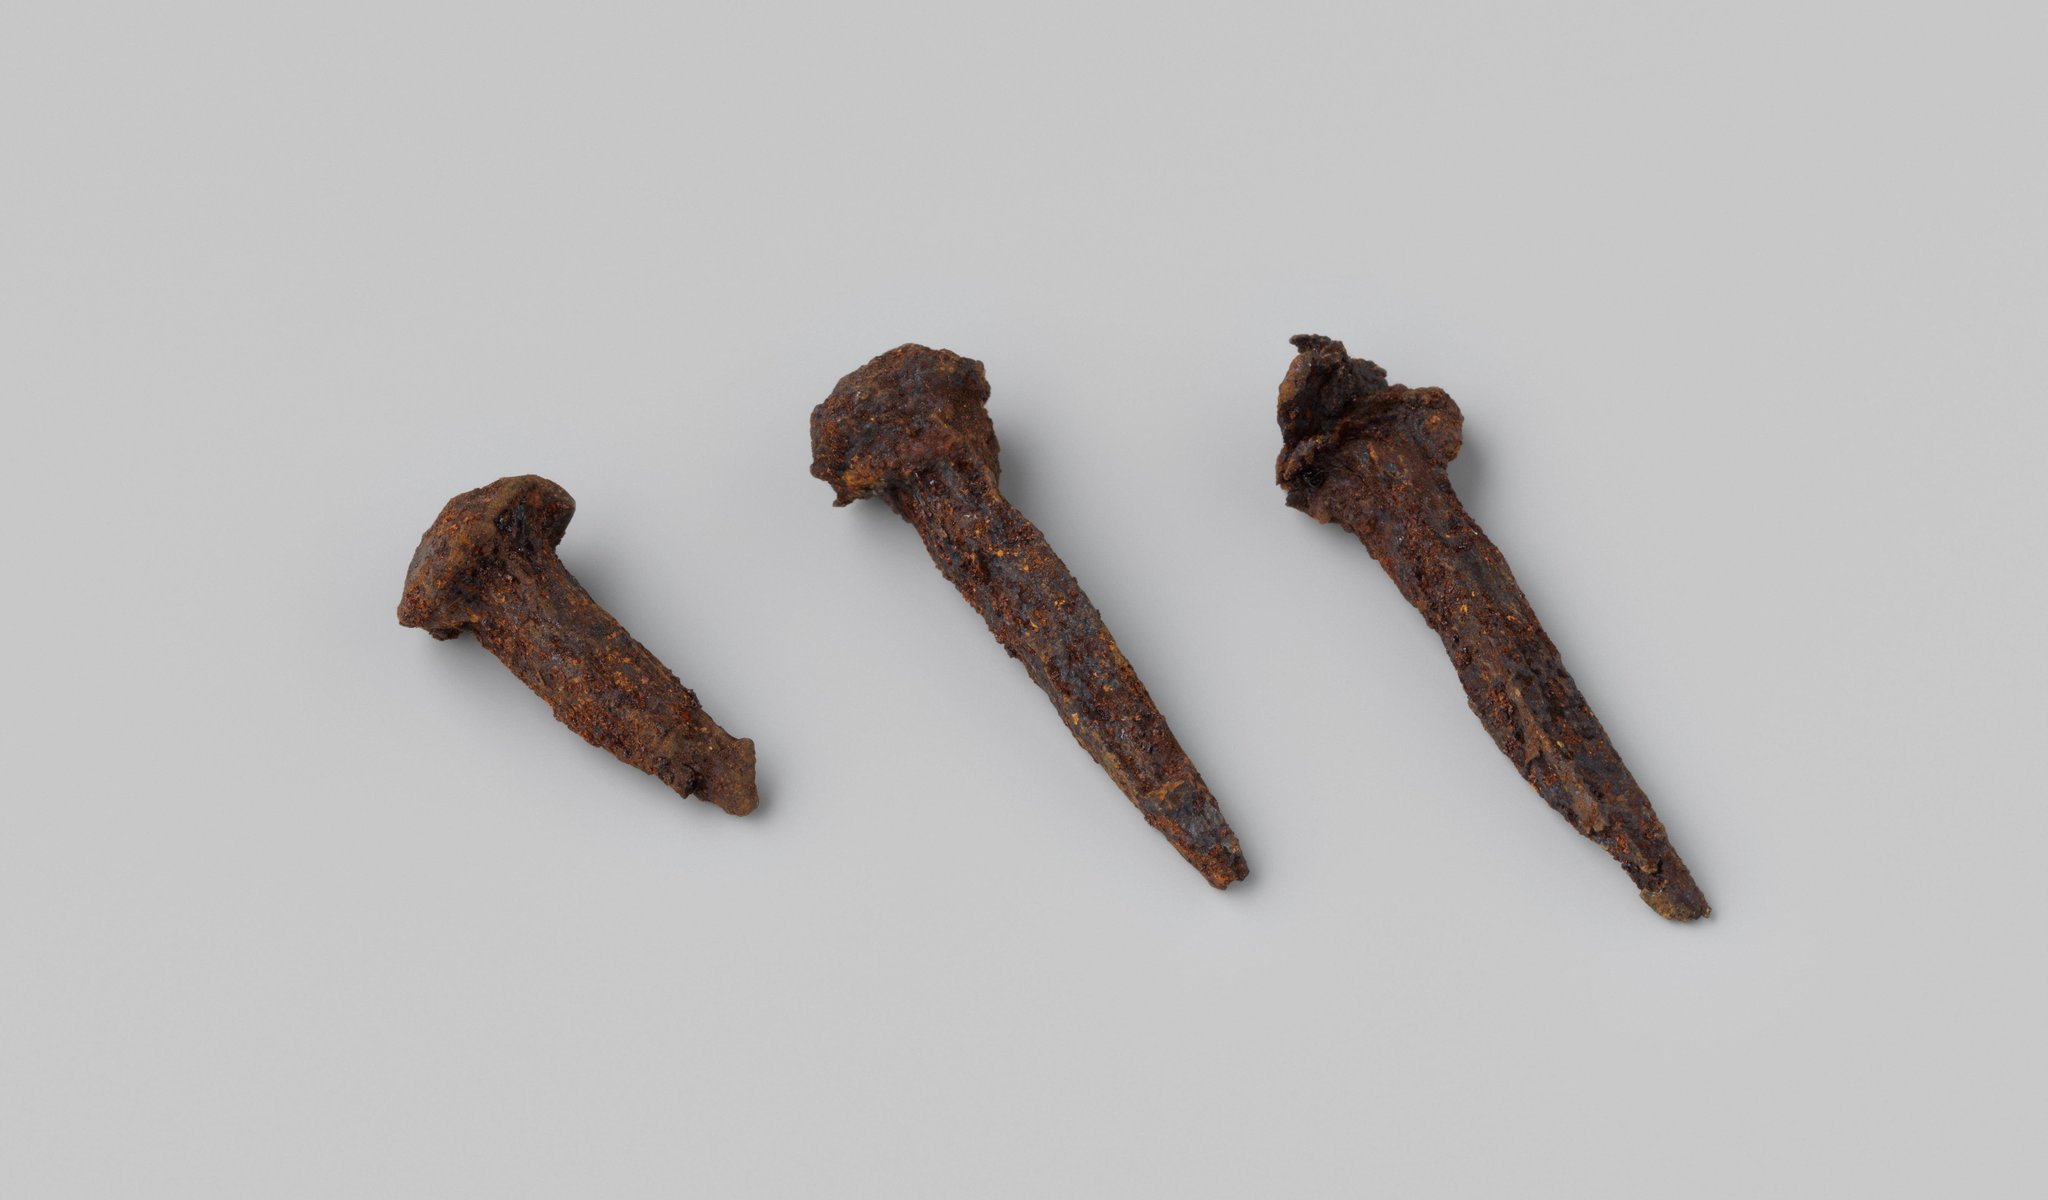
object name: nagel, spijker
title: Spijkers afkomstig uit het wrak van de Oost-Indiëvaarder Hollandia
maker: Anonymous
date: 1700-1743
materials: iron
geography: netherlands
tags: verenigde oostindische compagnie, hollandia (schip)